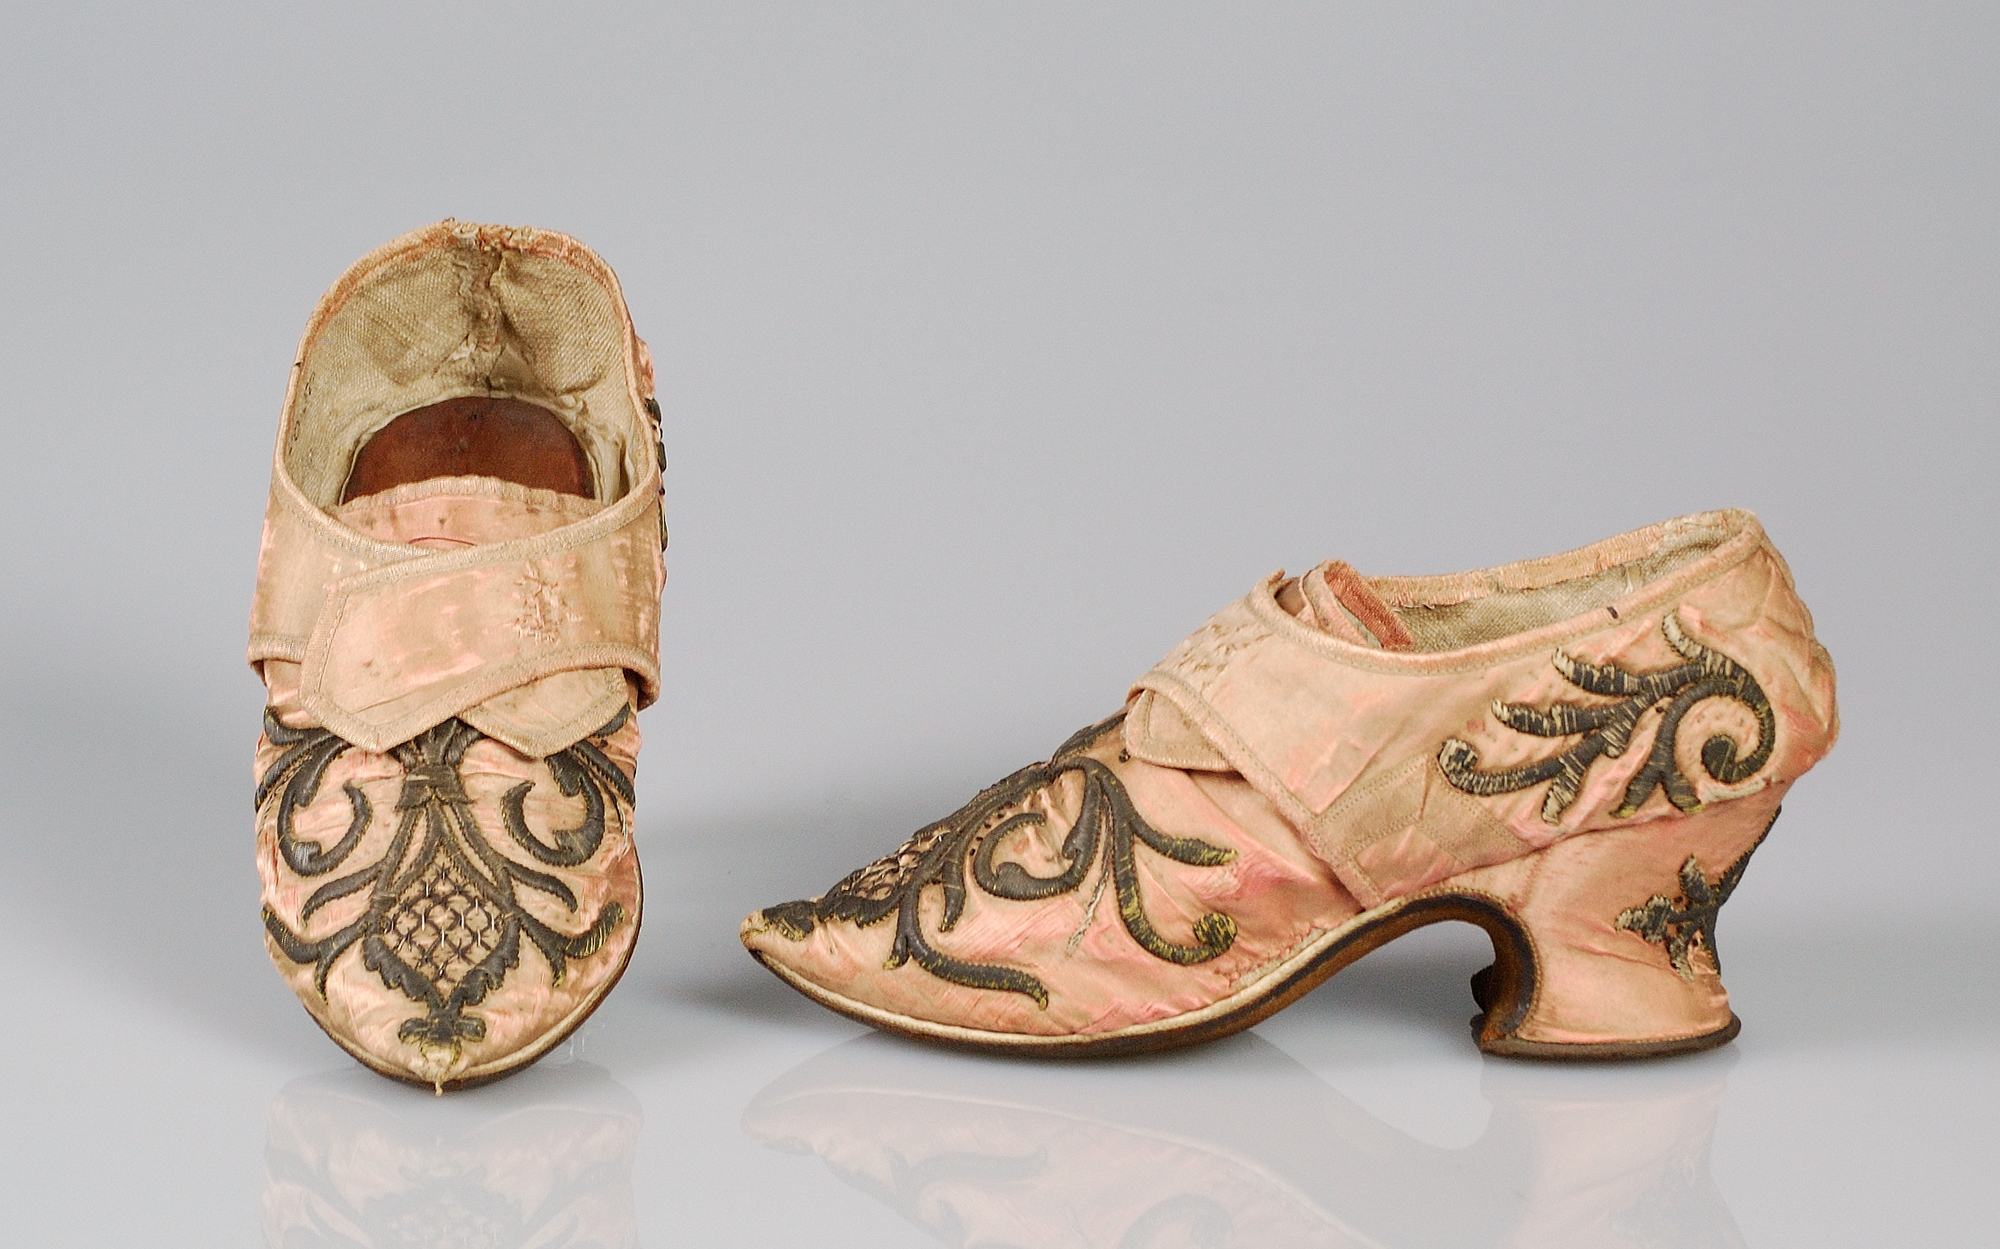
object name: shoe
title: Shoes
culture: british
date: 1710-1749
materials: silk